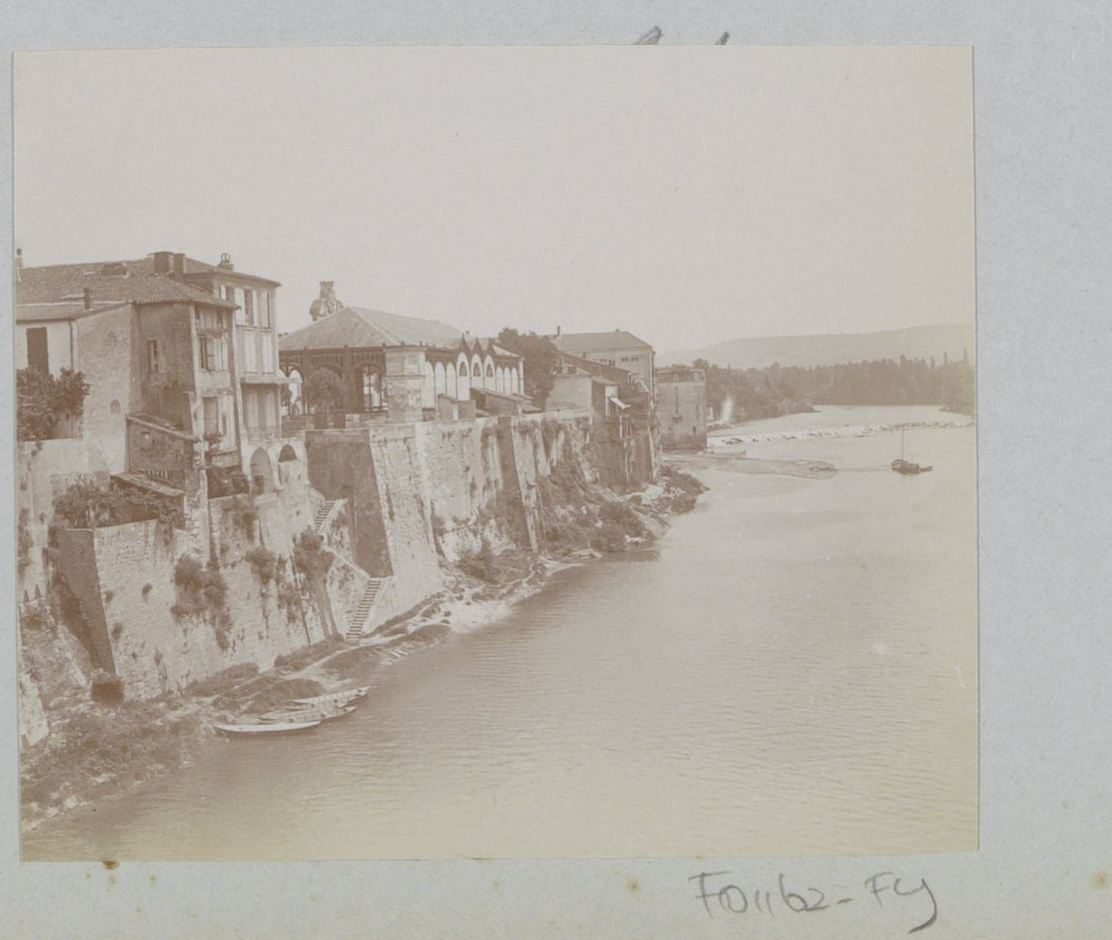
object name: photograph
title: Gezicht op een stad aan een rivier in Frankrijk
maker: Anonymous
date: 1905-1910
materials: paper, photographic support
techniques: gelatin silver print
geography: france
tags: river bank, river (+ landscape with figures, staffage), prospect of city, town panorama, silhouette of city, france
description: Onderdeel van Fotoalbum van een Franse amateurfotograaf met bezienswaardigheden in Frankrijk, Zwitserland en Italië.